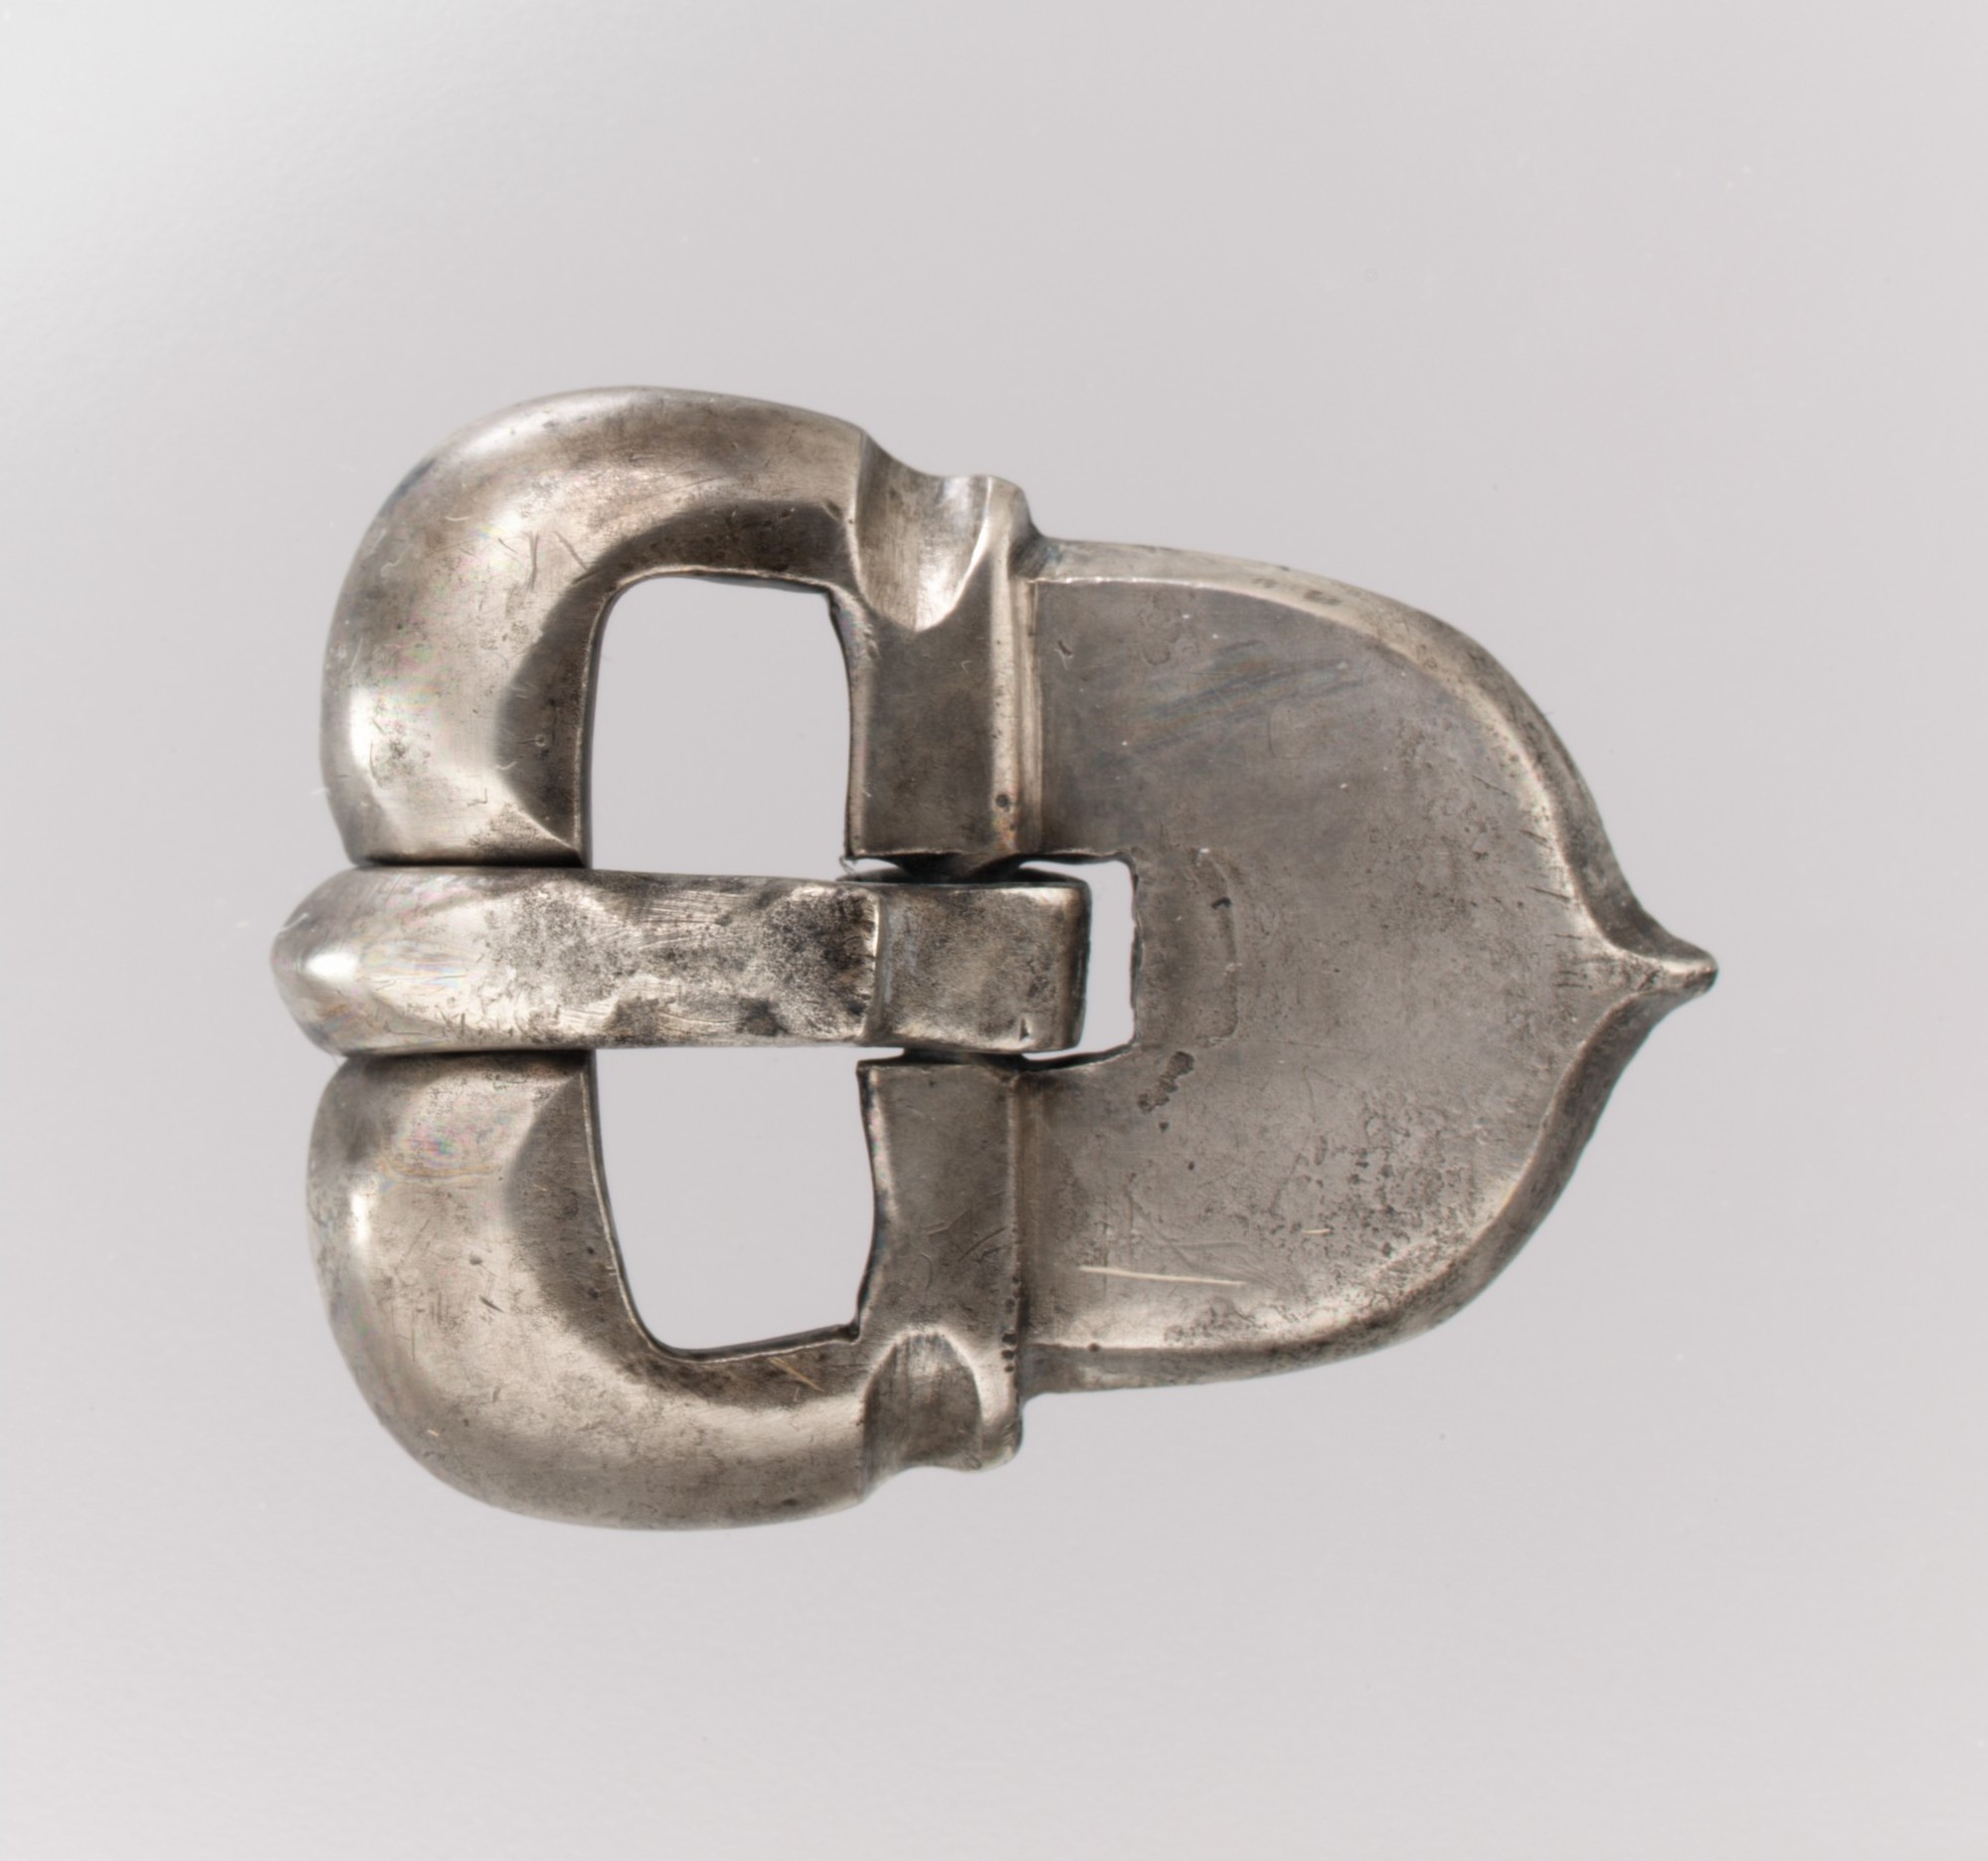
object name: shoe buckle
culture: byzantine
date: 601-700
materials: silver